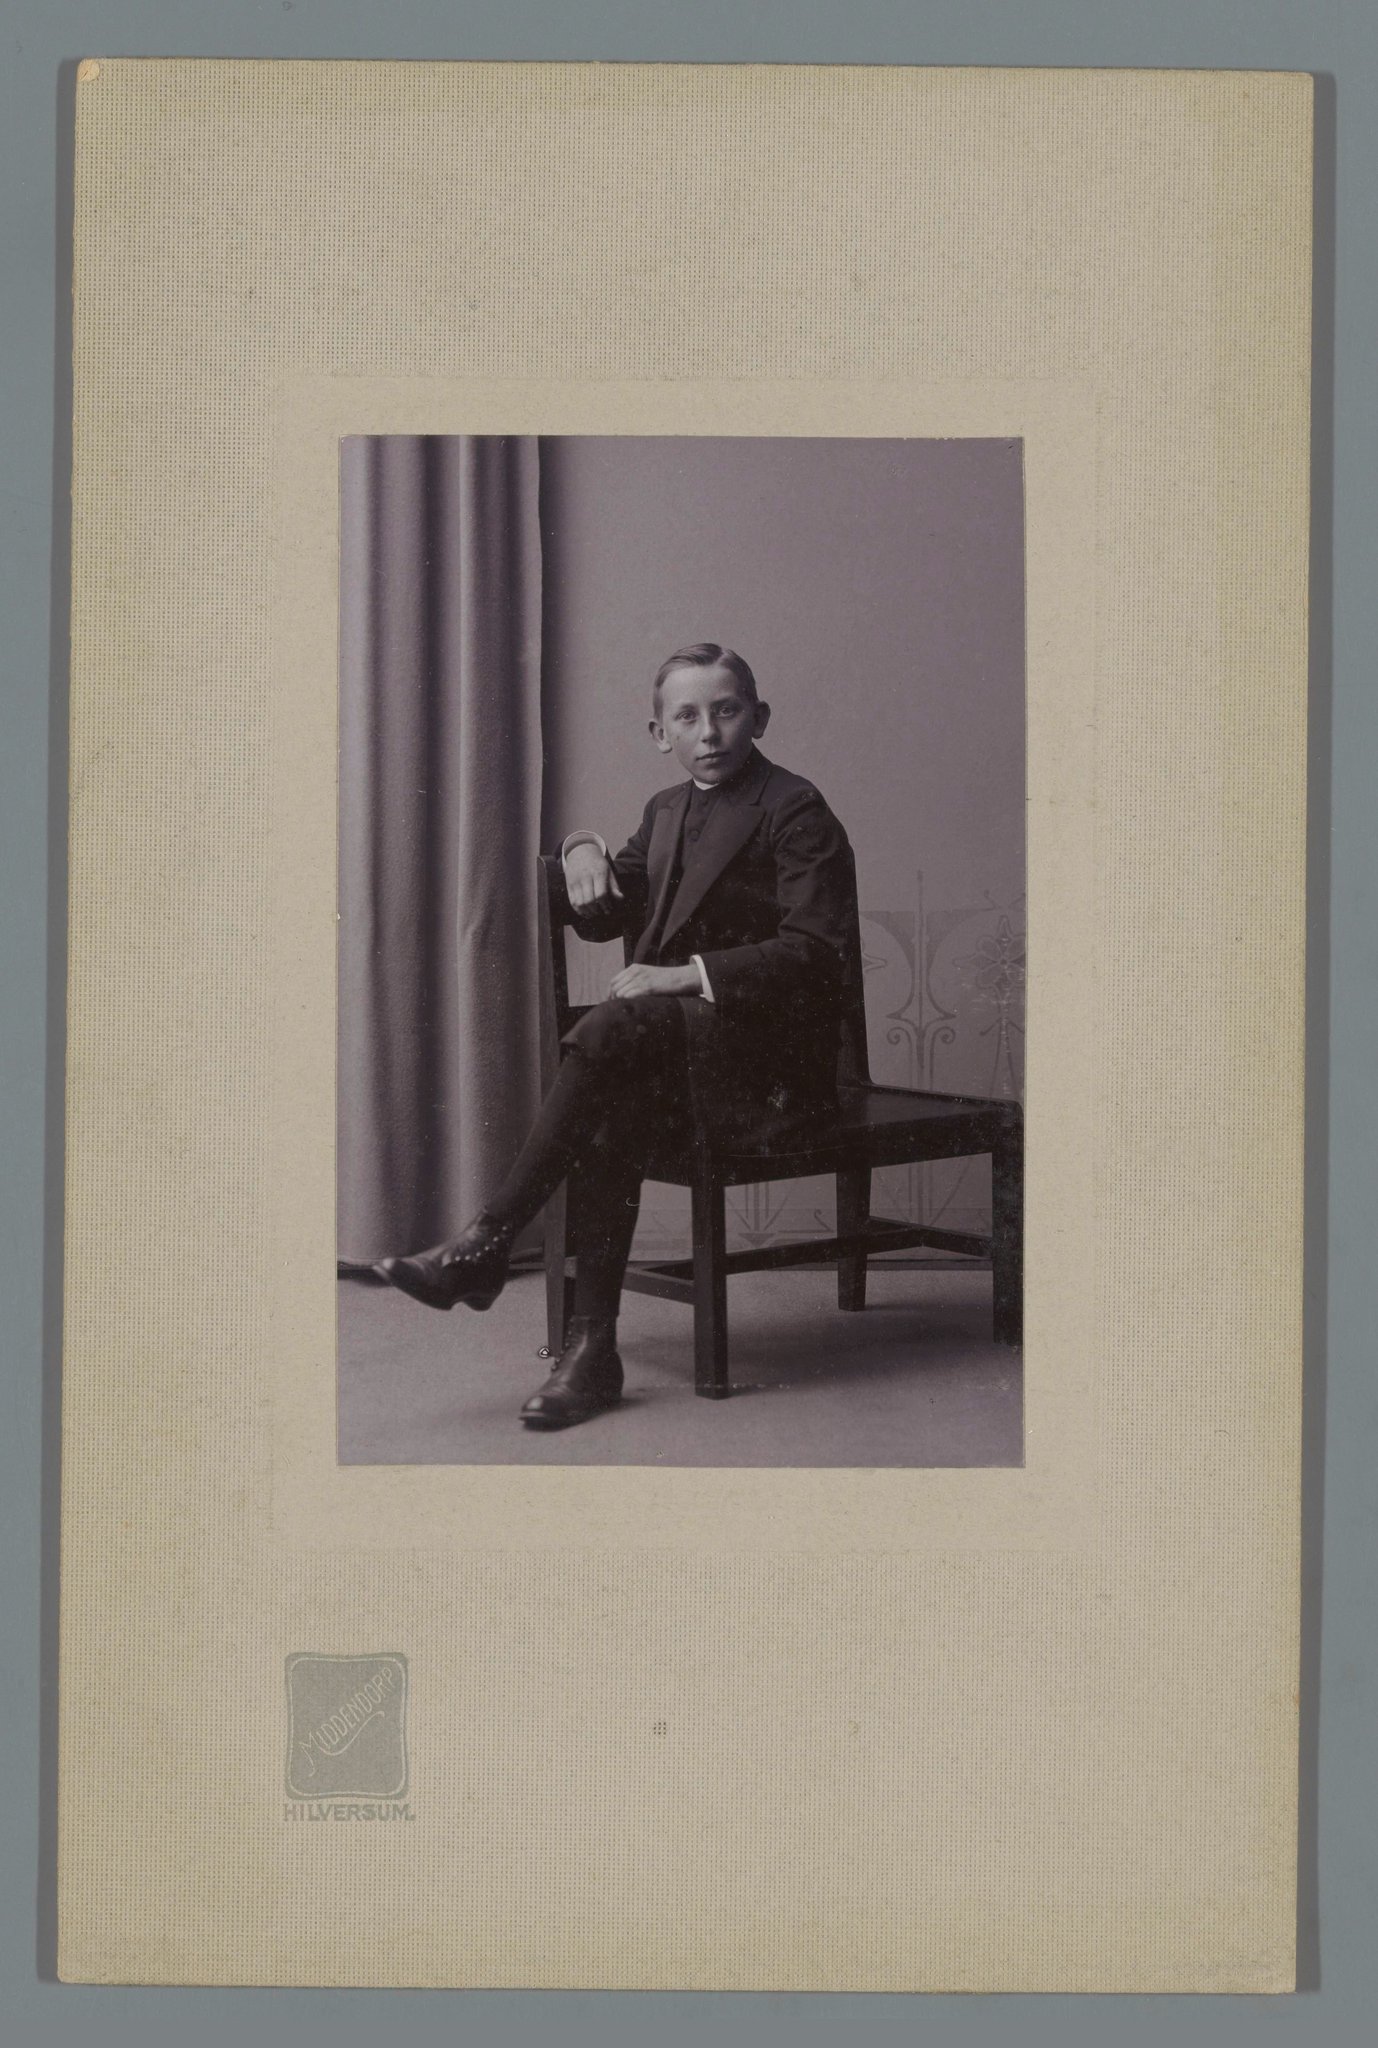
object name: cabinet photograph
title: Portret van een onbekende jongen op een stoel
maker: johannes gerard middendorp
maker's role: fotograaf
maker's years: 1870-1949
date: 1900-1948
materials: cardboard, photographic support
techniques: collodion silver print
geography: hilversum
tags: studio requisites ~ photographer, boy (child between toddler and youth)